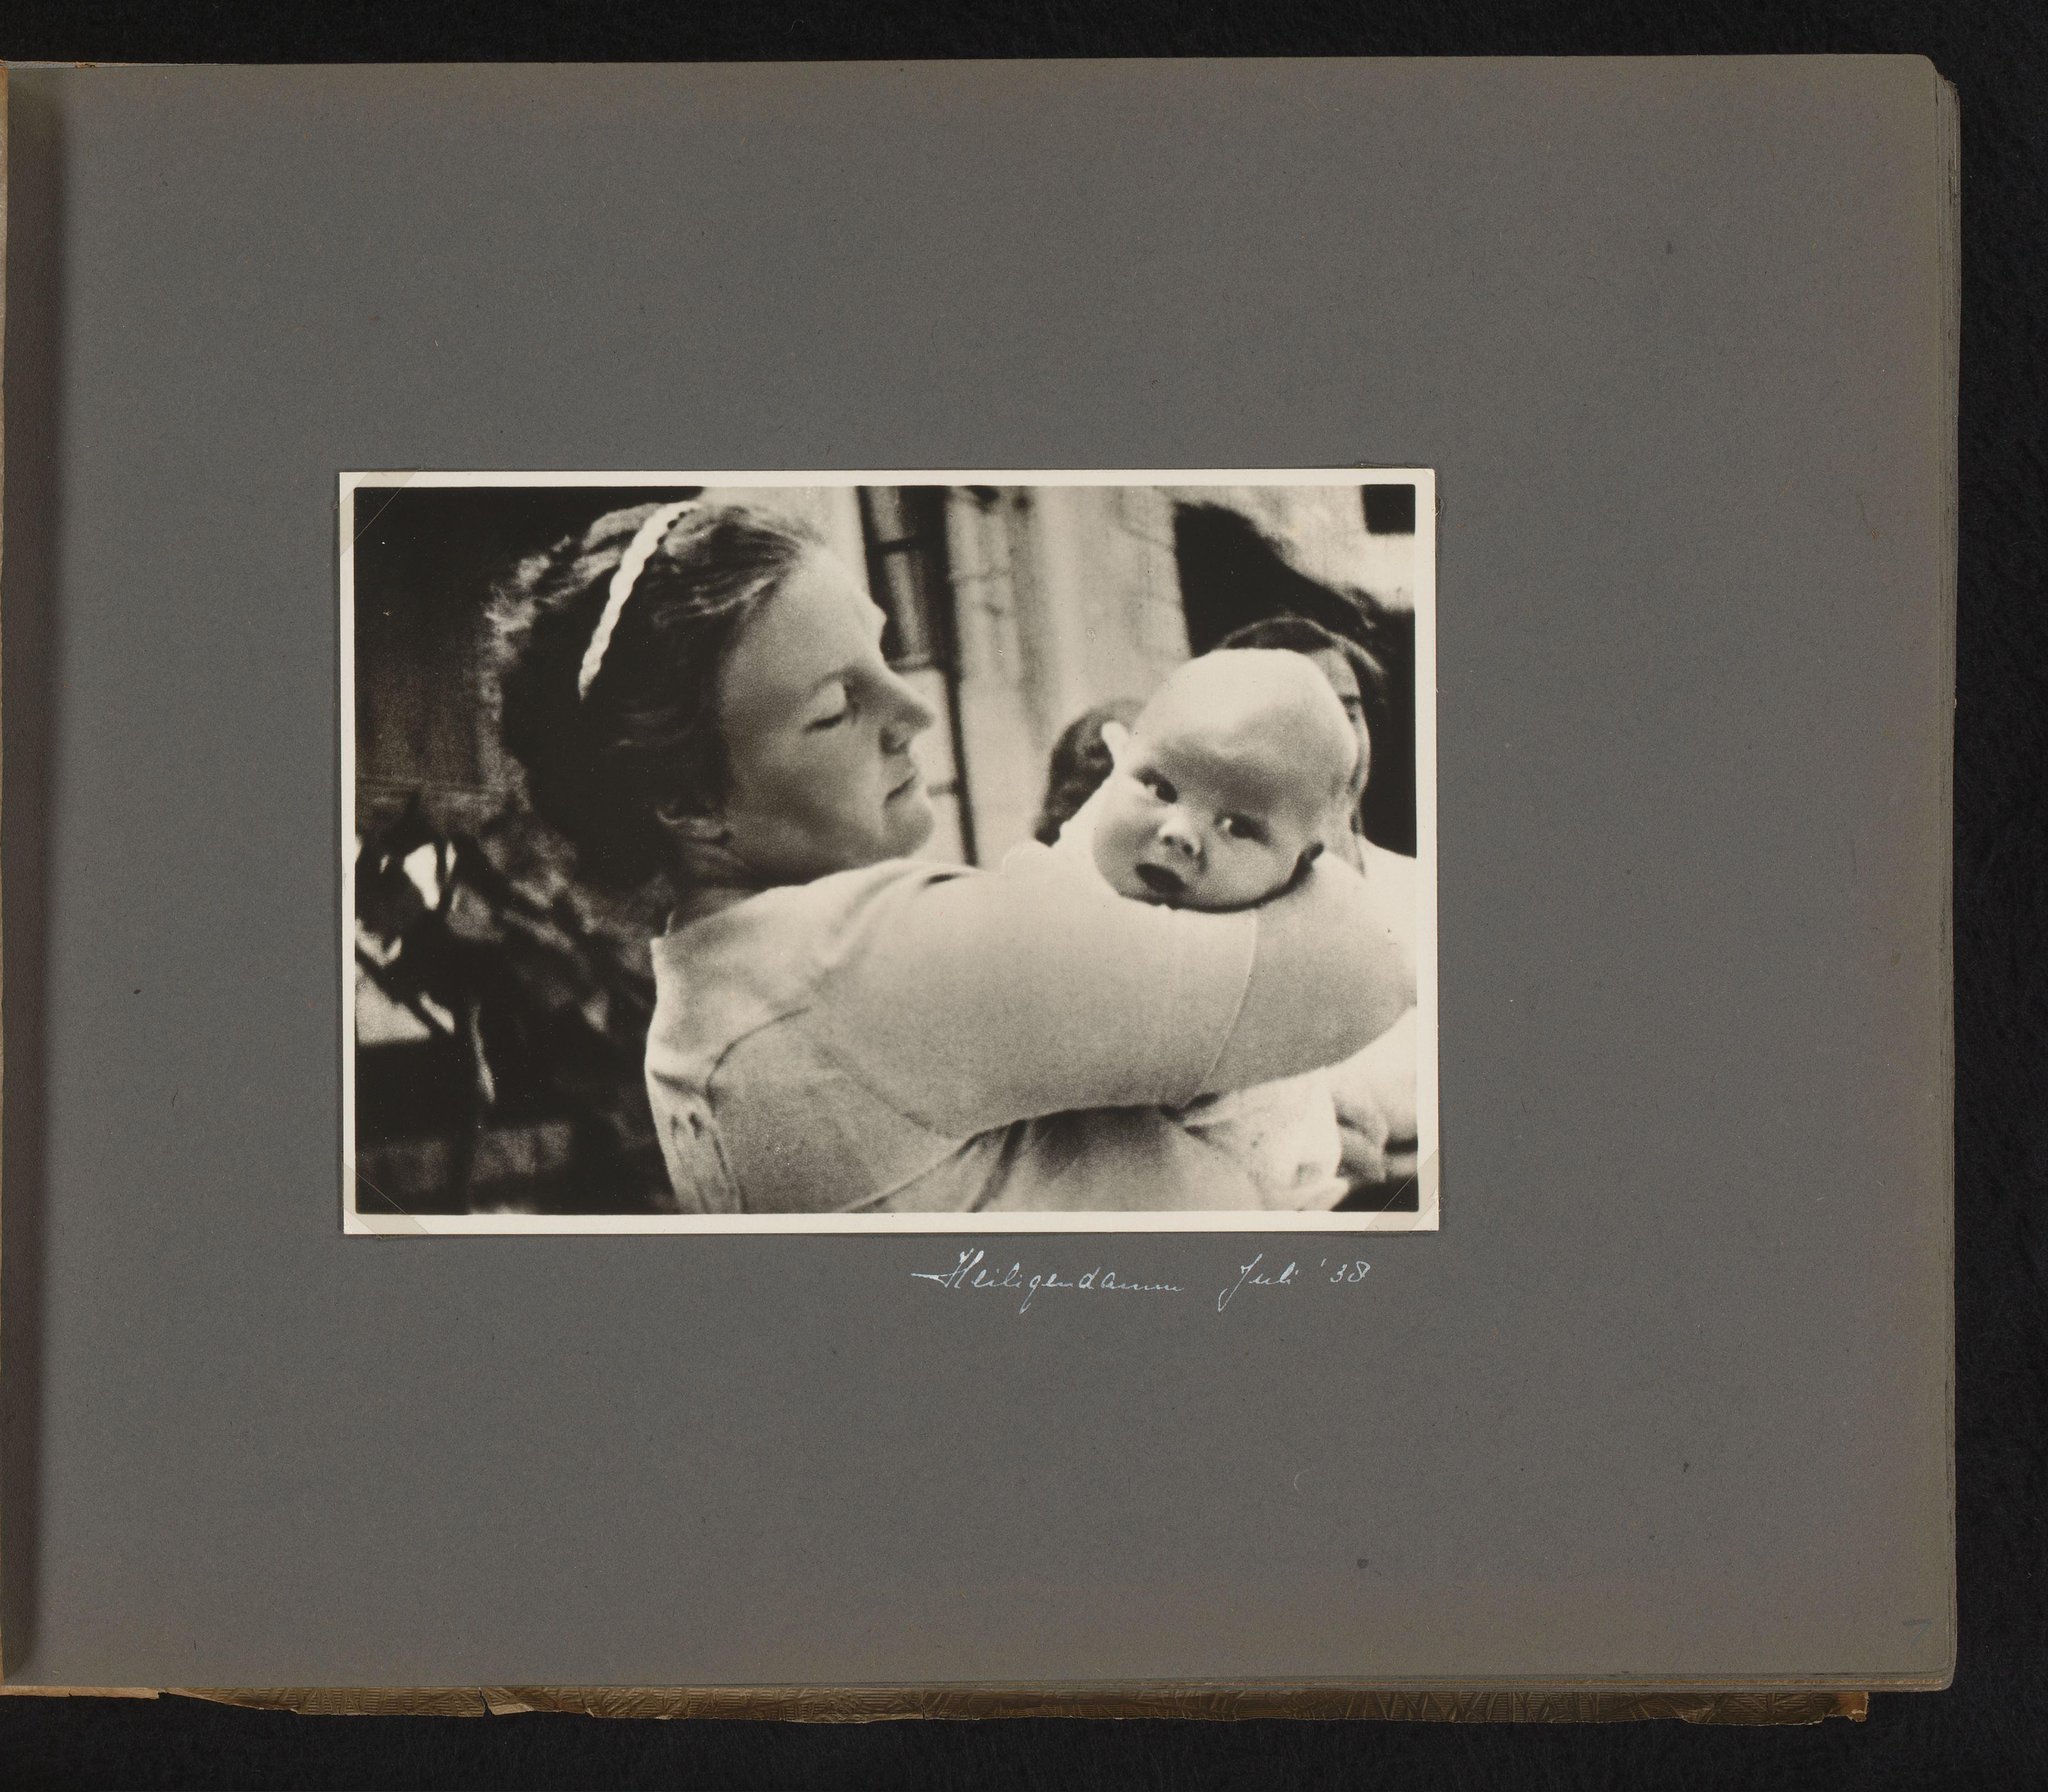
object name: photograph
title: Heiligendamm, Juli 1938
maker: Anonymous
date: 1907-1938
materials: cardboard, photographic support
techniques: gelatin silver print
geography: amsterdam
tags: beatrix (koningin der nederlanden), the hague, juliana of the netherlands, parents with their children, mother and baby or young child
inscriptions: date: ‘Heiligendamm Juli '38’, number: ‘247’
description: Albumblad met een foto's van prinses Juliana met prinses Beatrix, juli 1938 in Heiligendamm. Onderdeel van fotoalbum over het familieleven van de leden van het Koninklijk Huis tussen 1937-1945.